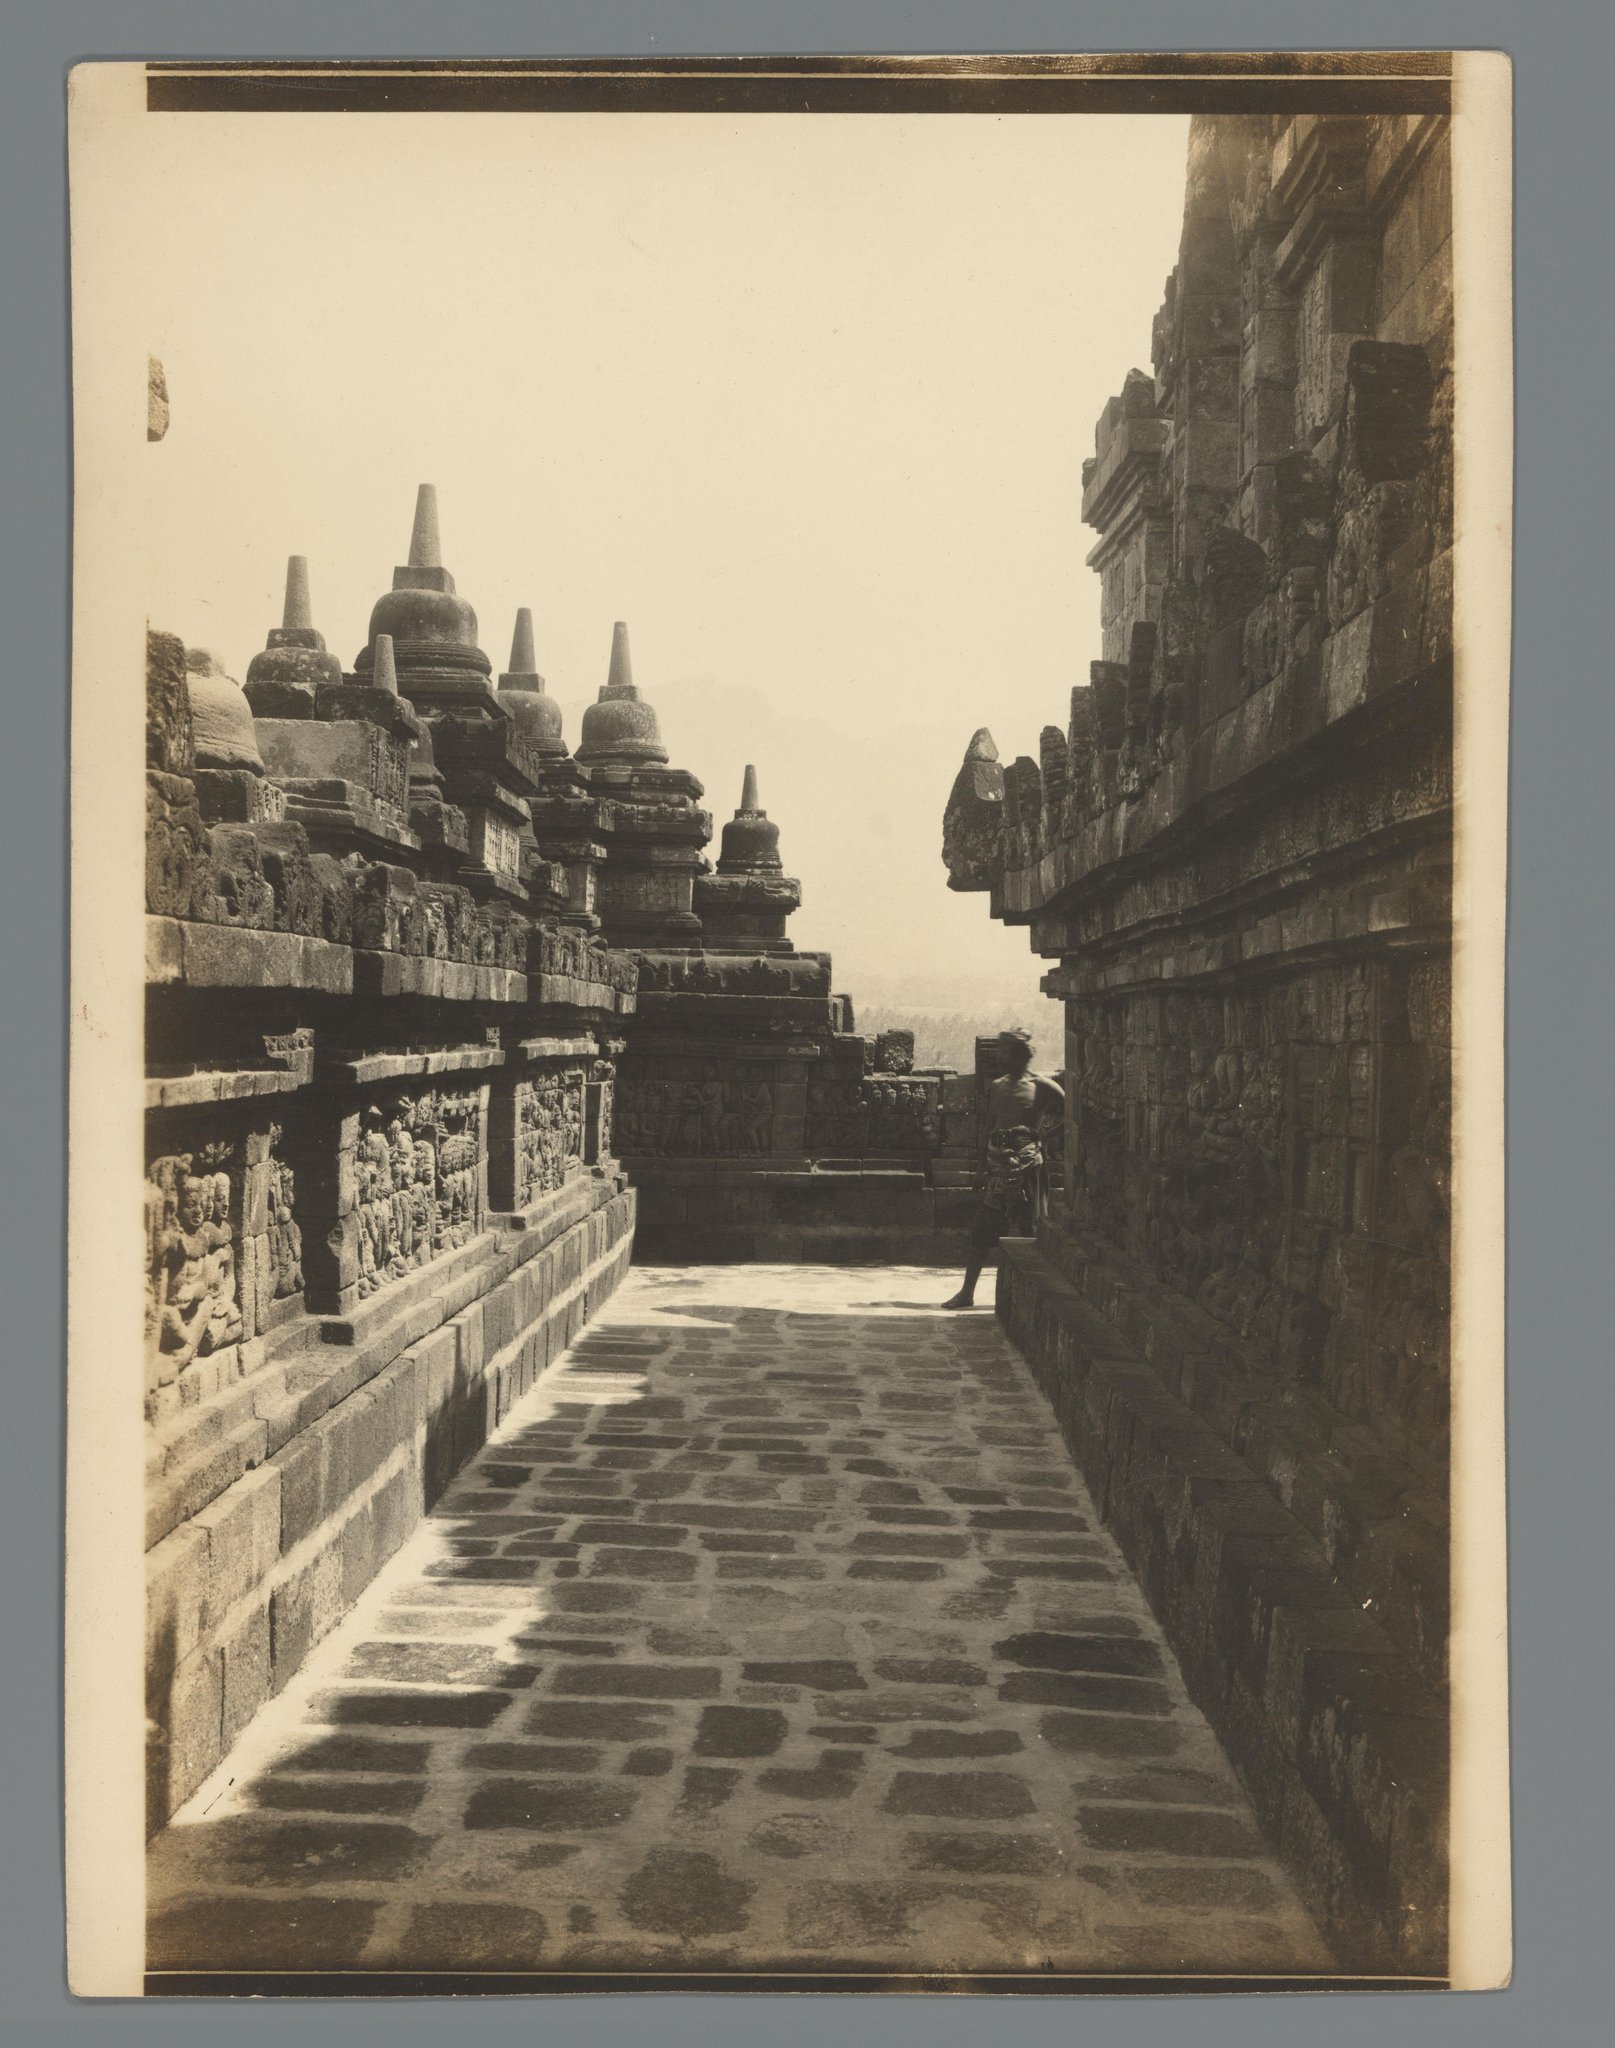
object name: photograph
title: Boeddhistisch tempelcomplex in Indonesië, mogelijk de Borobudur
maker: Anonymous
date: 1921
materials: paper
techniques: gelatin silver print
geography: central java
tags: temple, shrine ~ hinduism, buddhism, jainism